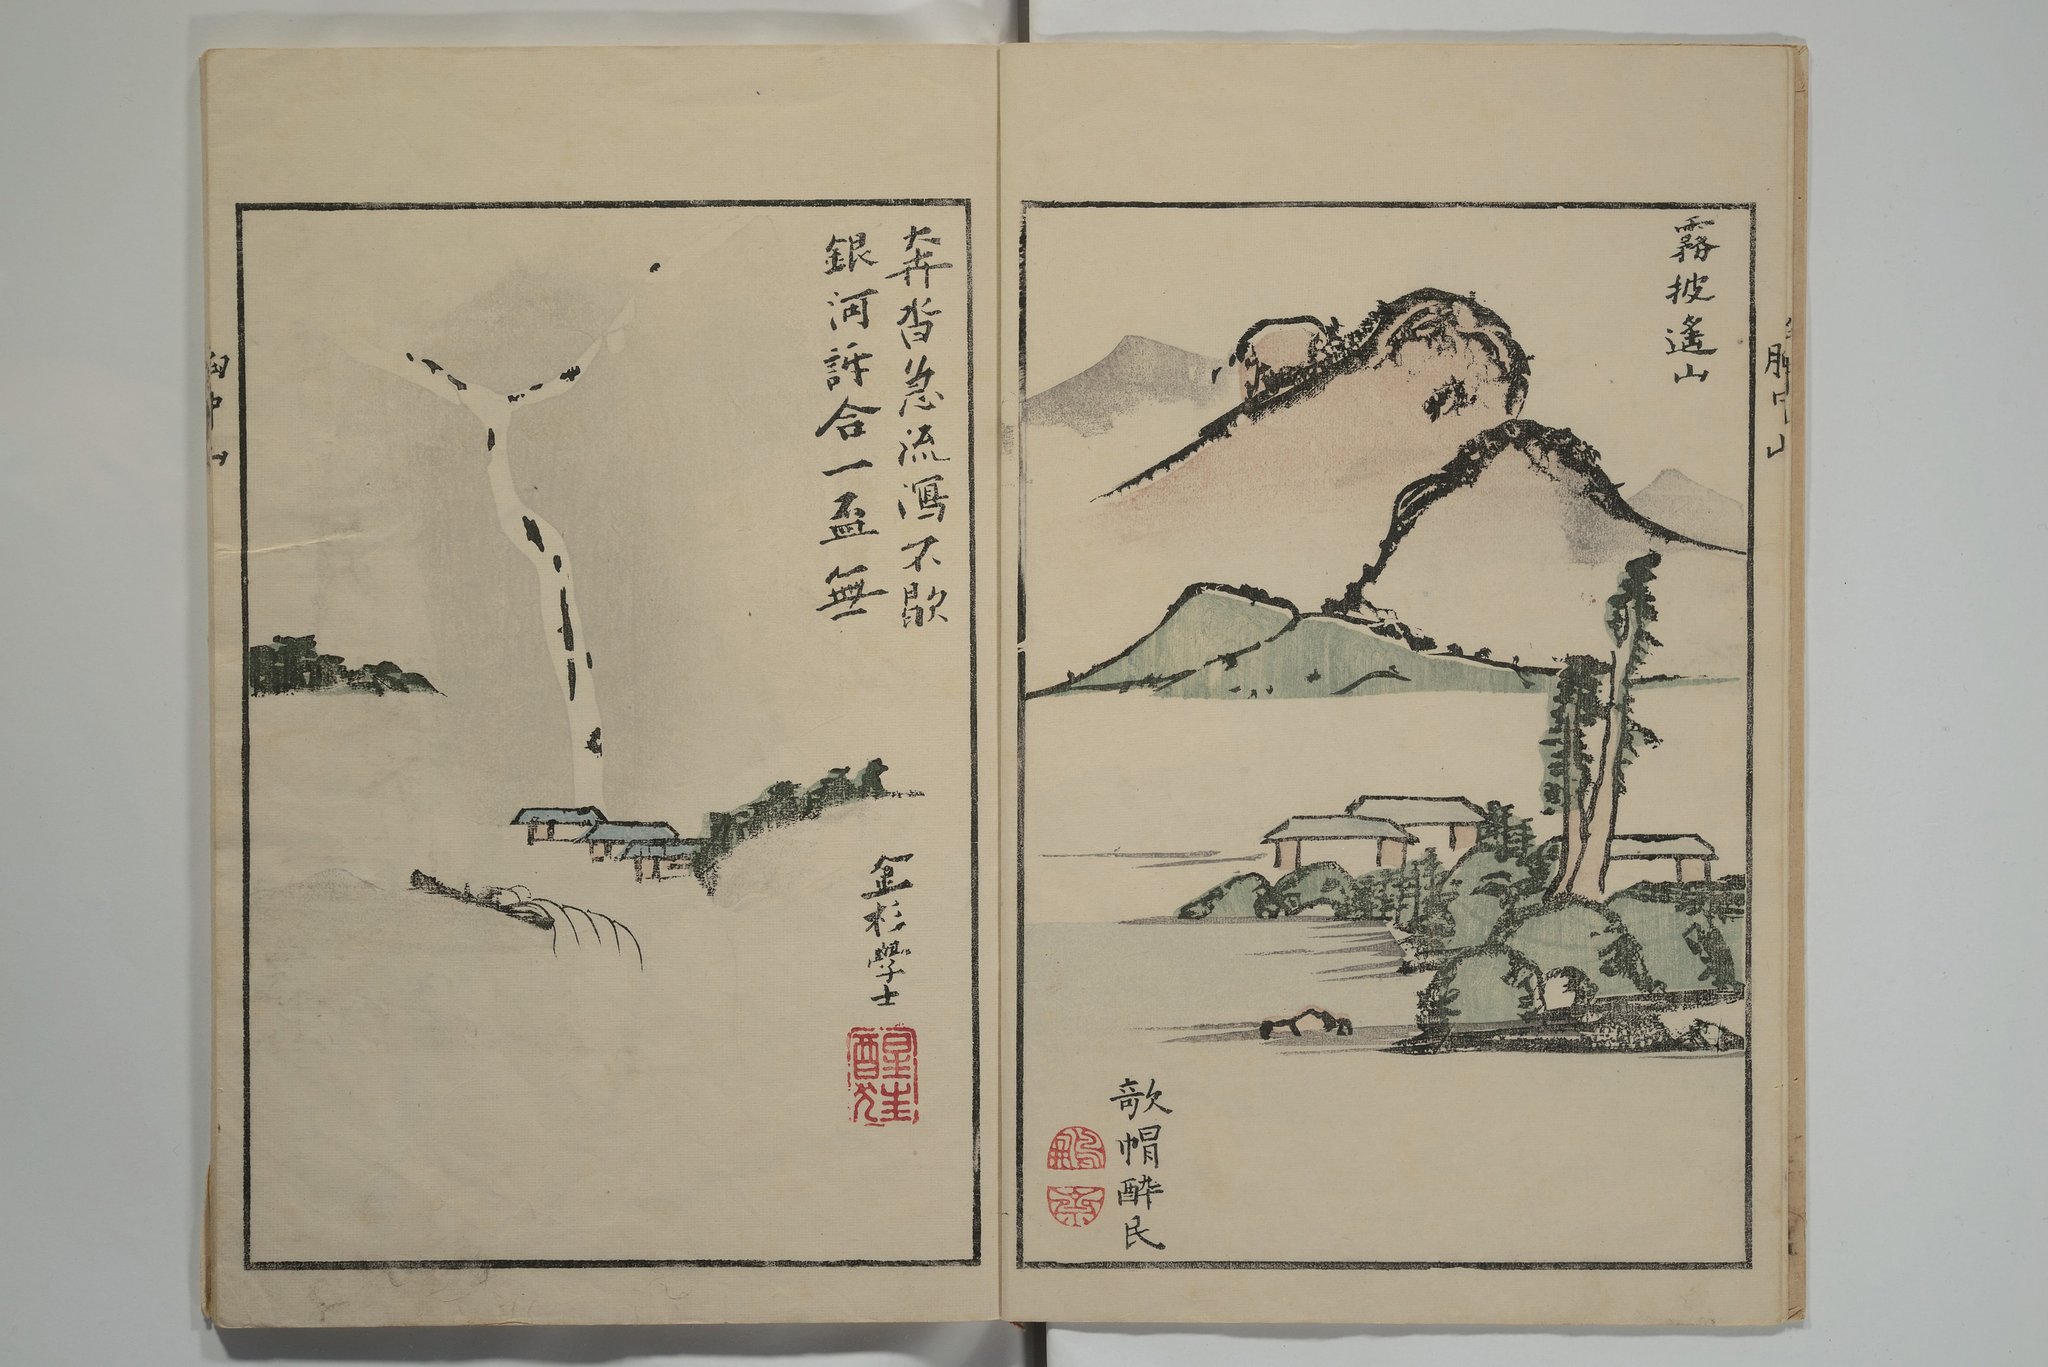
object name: illustrated book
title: Mountains of the Heart (Kyōchūzan) 胸中山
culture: japanese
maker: kameda bōsai 亀田鵬斎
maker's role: artist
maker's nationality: japanese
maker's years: 1752-1826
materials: ink, paper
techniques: woodblock print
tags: houses,mountains